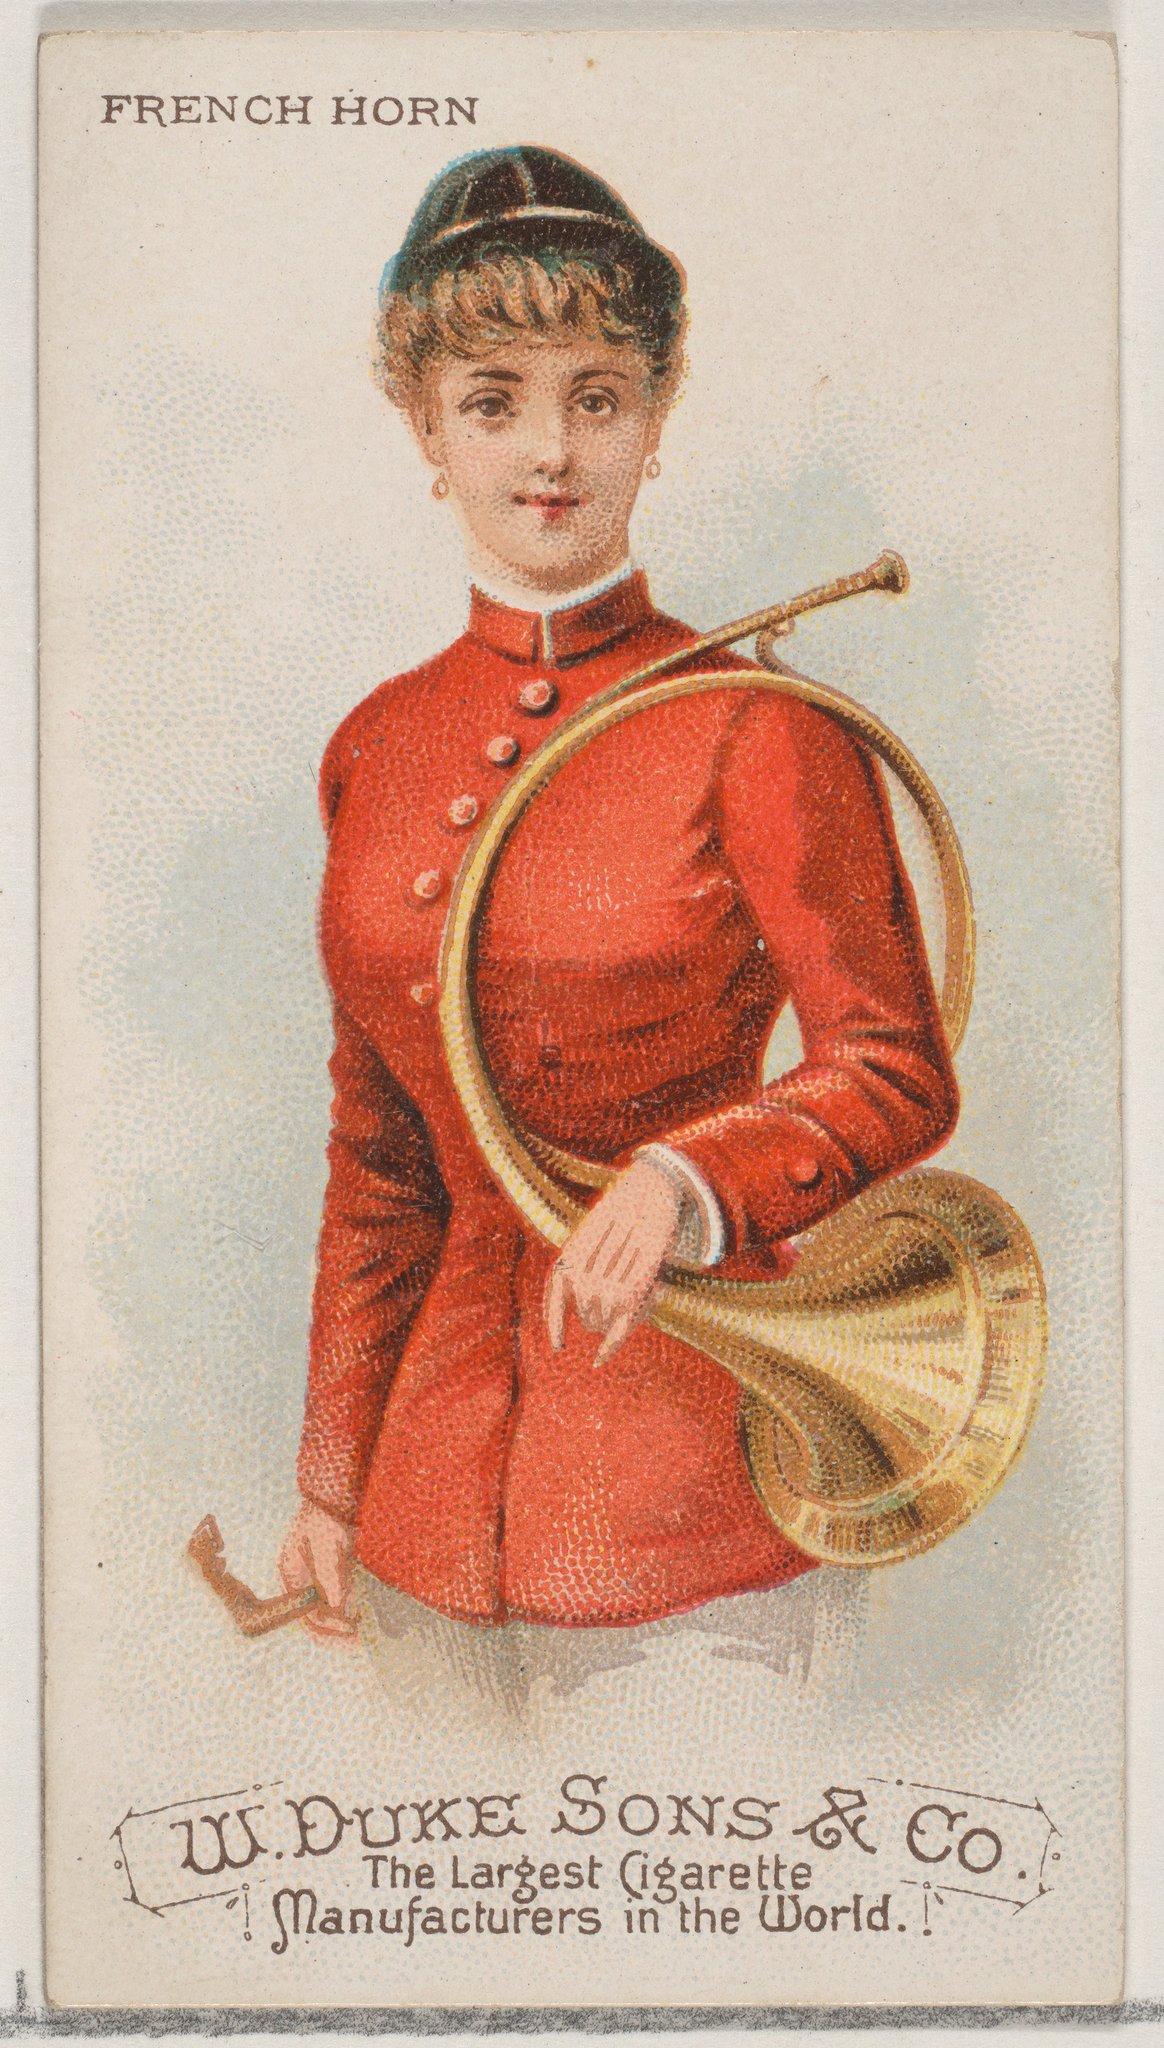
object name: print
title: French Horn, from the Musical Instruments series (N82) for Duke brand cigarettes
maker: w. duke, sons & co.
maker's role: publisher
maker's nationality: american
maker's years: 1870-1920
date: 1888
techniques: color lithograph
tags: musical instruments,women,musicians